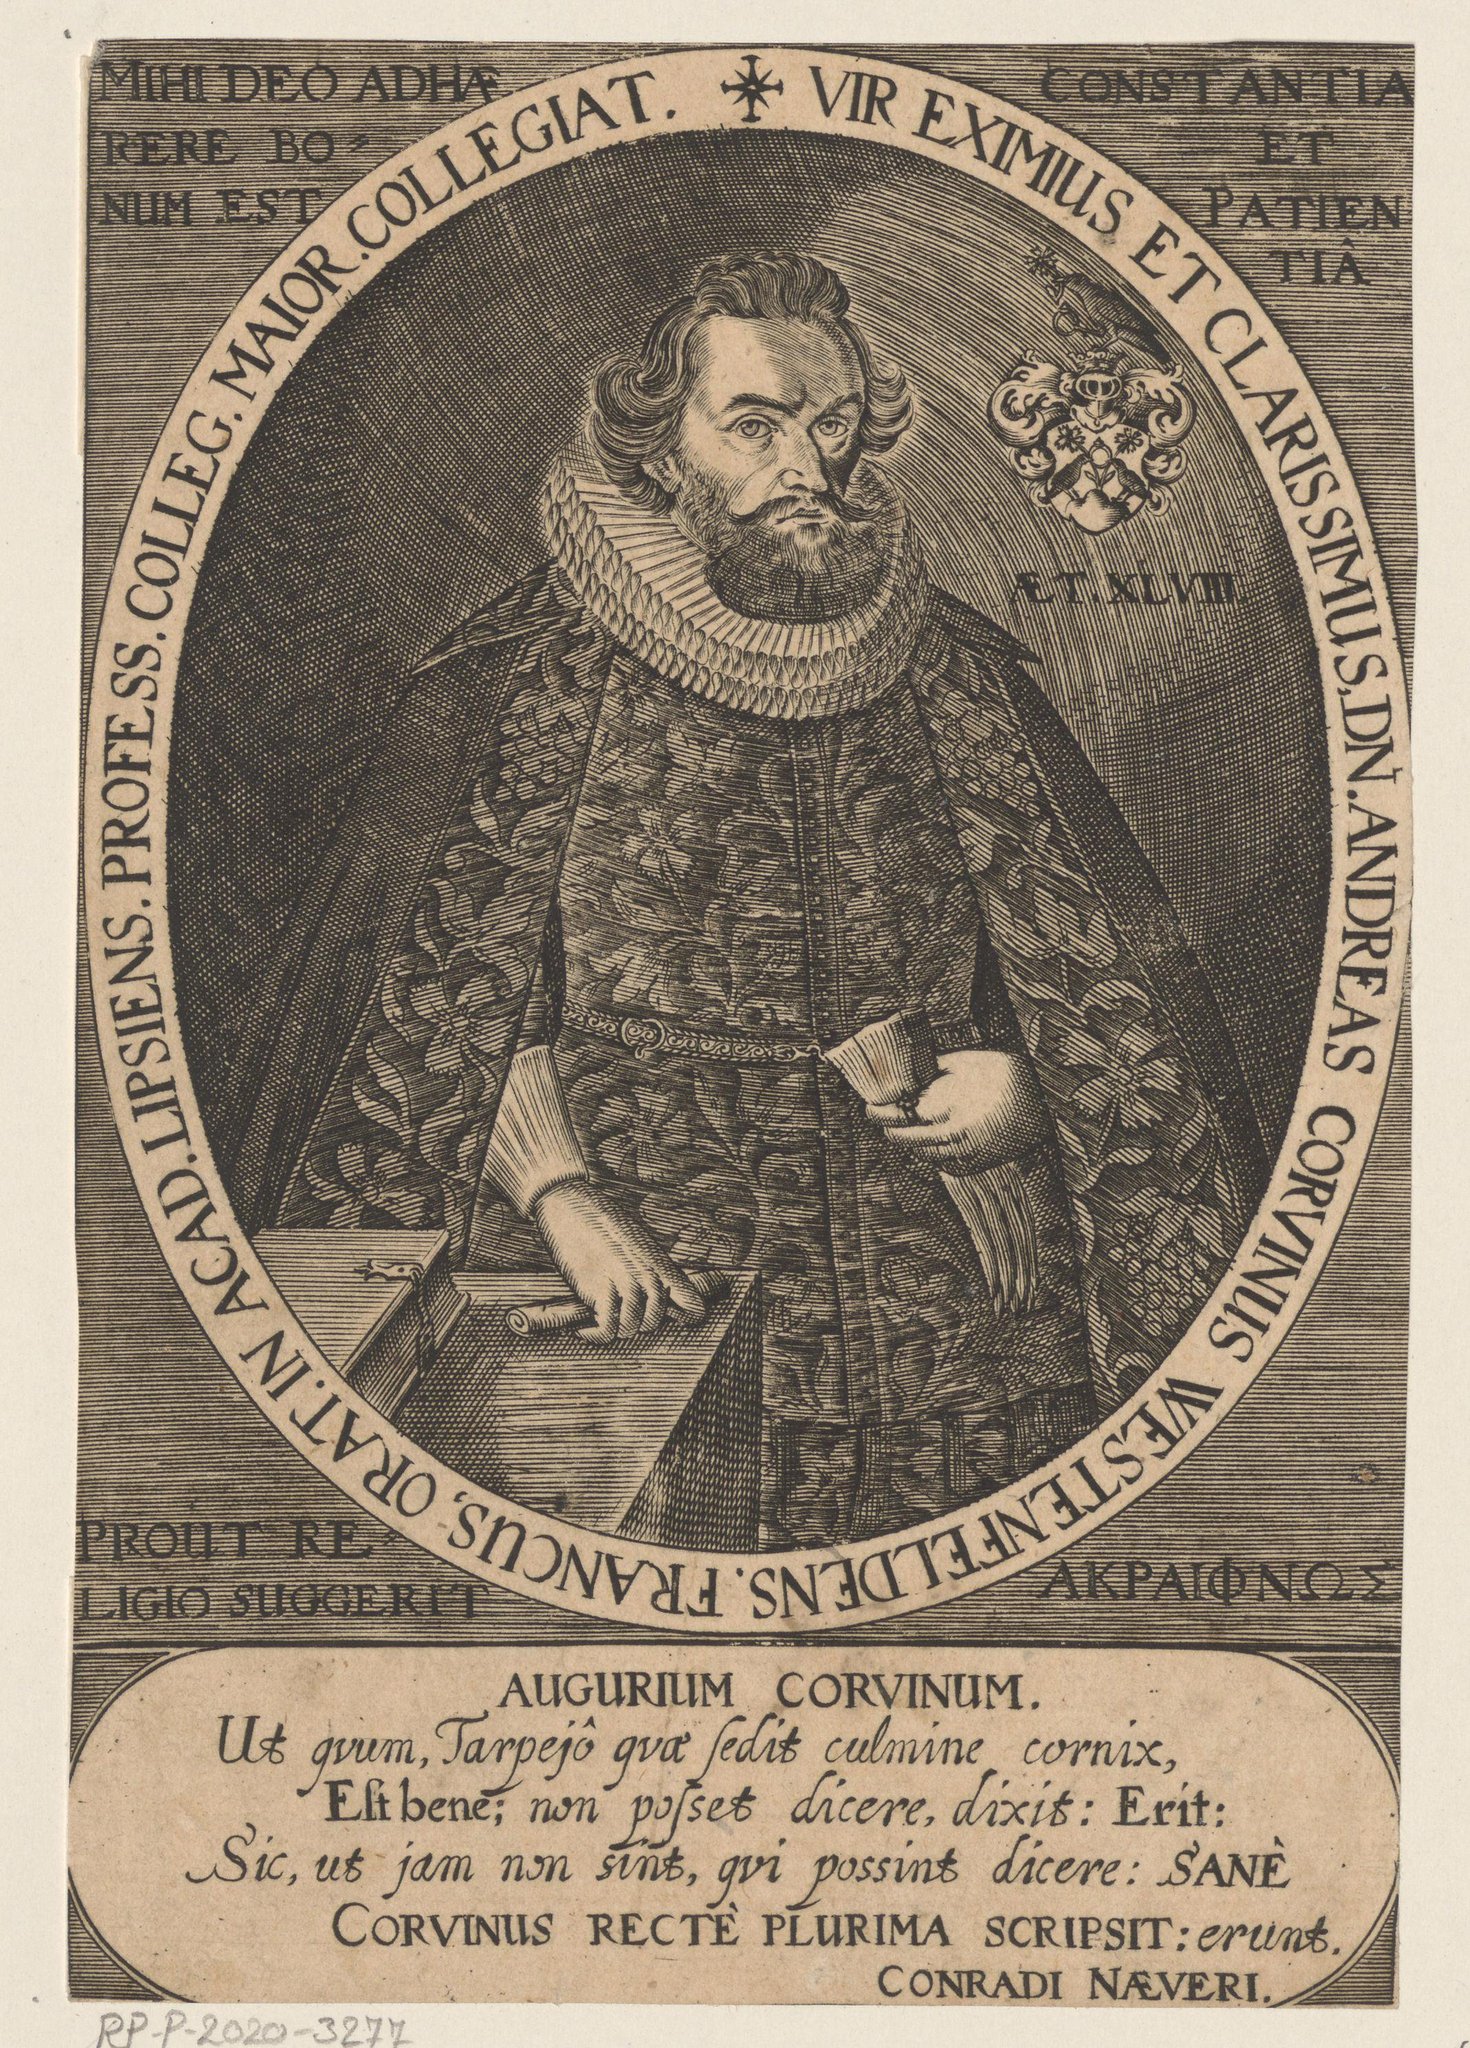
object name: print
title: Portret van Andreas Corvinus op 48-jarige leeftijd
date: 1637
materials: paper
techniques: engraving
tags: historical persons